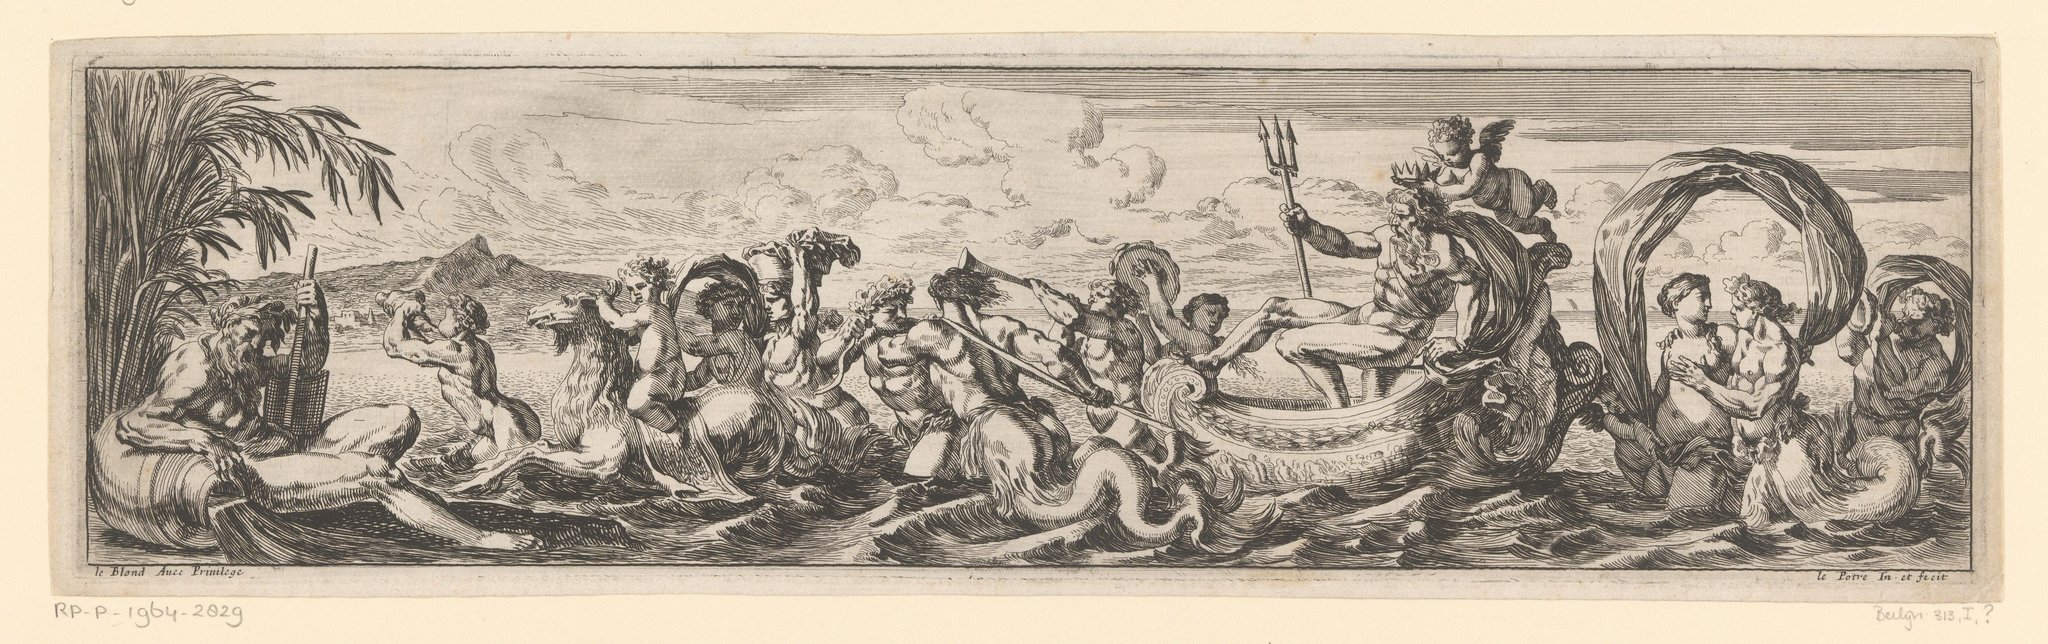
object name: ornament print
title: Friezen met zeegoden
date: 1628-1682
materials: paper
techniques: etching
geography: paris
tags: triumph of neptune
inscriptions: collector's mark: Lugt 2228, collector's mark: Lugt 2760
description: Fries met de triomf van Neptunus. De zeegod zit in een wagen getrokken door meermannen. Een putto kroont Neptunus. Voor en achter de wagen lopen meermannen- en vrouwen met muziekinstrumenten, schelpen en manden en zit een putto op een zeegeit.